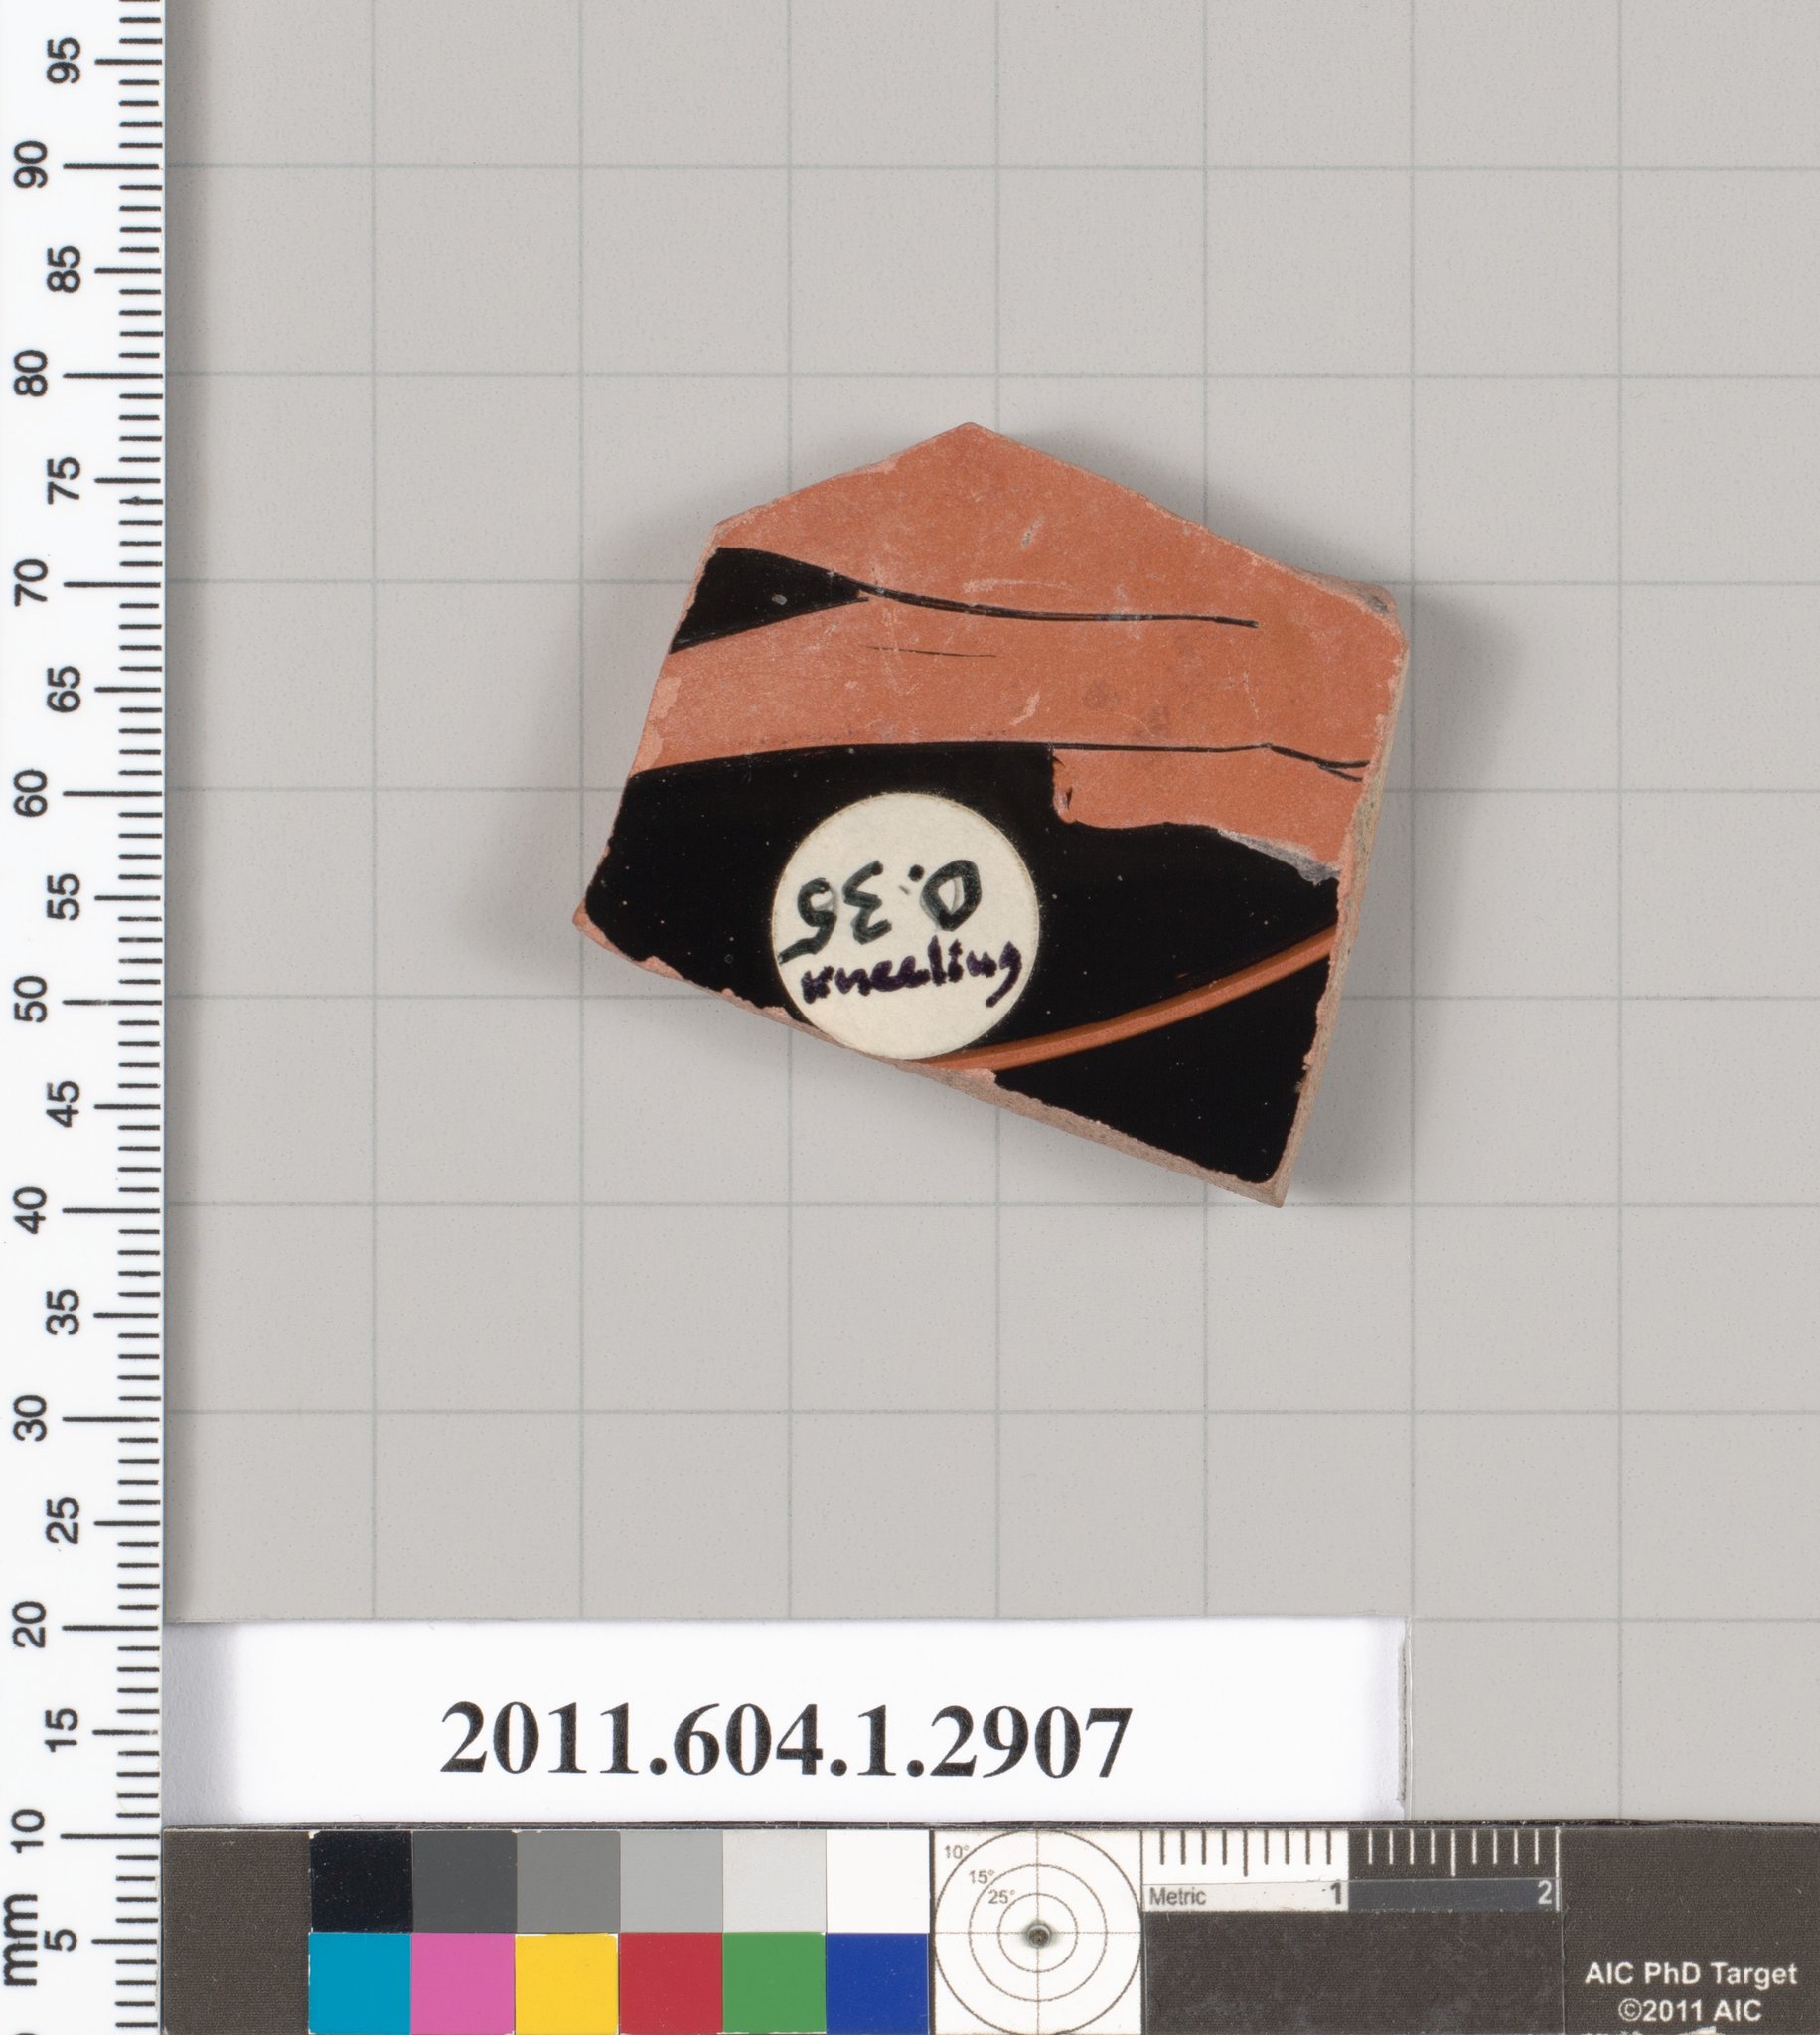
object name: kylix fragment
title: Terracotta fragment of a kylix (drinking cup)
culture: greek, attic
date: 500-490 BCE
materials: terracotta